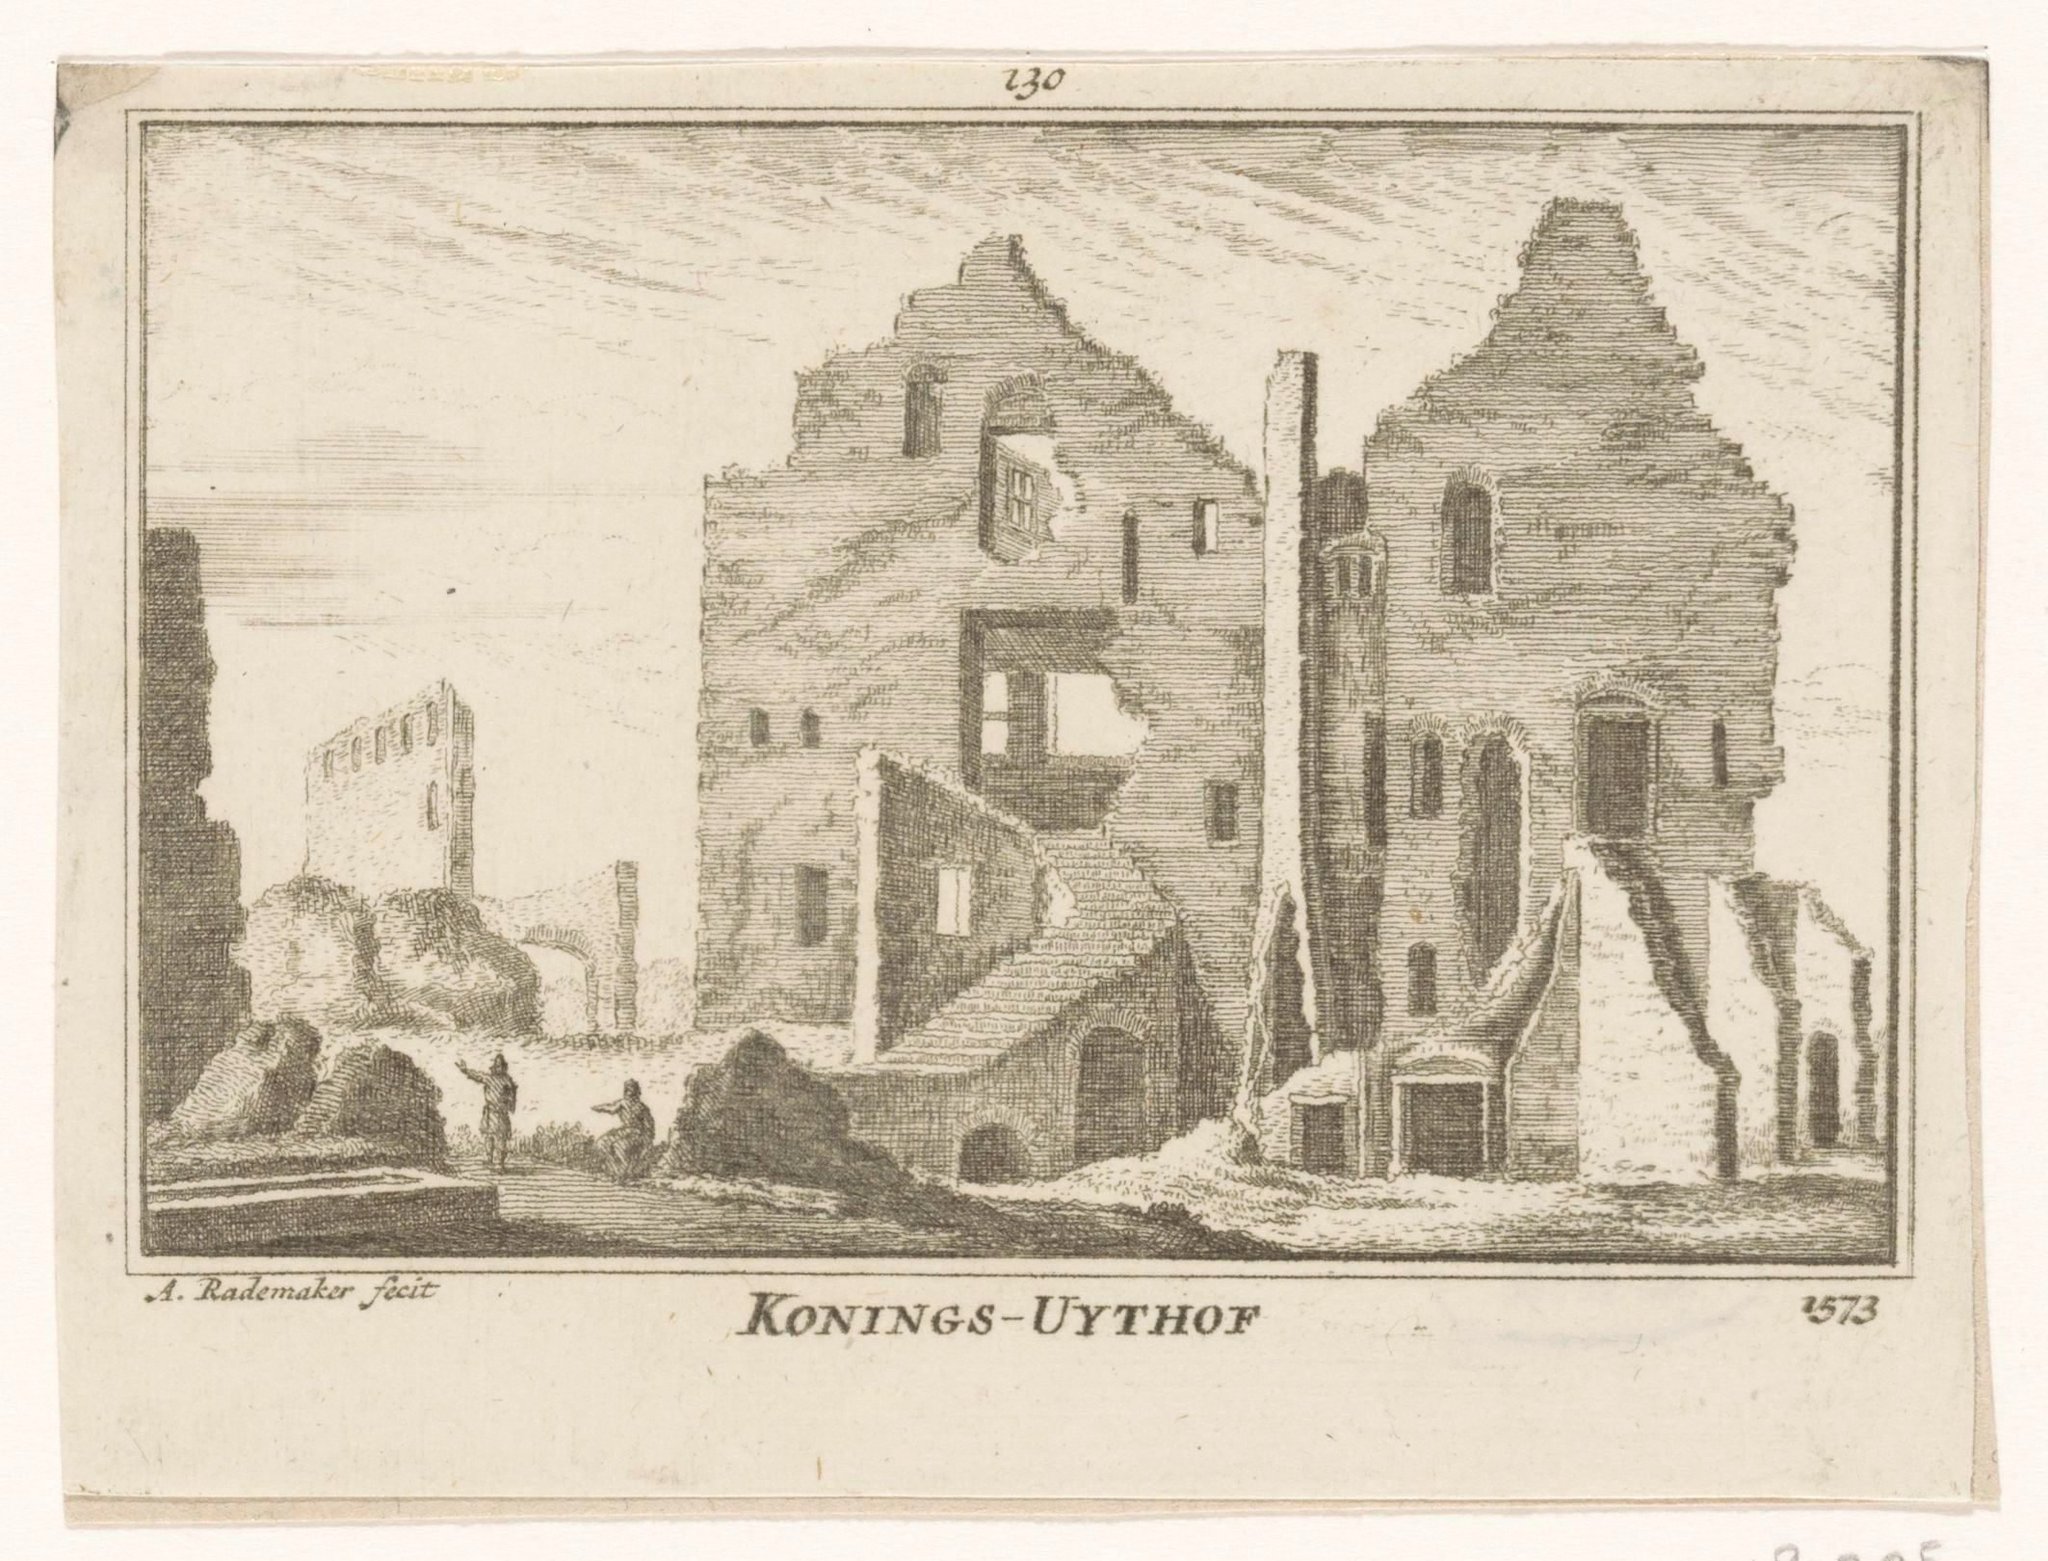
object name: print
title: Konings-Uythof 1573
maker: abraham rademaker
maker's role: draughtsman, print maker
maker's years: 1676-1735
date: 1725-1803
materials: paper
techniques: engraving, etching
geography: amsterdam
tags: ruin of church, monastery, etc., staircase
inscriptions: collector's mark: Lugt 2228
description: Prent ook gebruikt in: Rademaker, Abraham. Kabinet van Nederlandsche outheden en gezichten: vervat in 300 konstplaaten (…). 2 delen. Amsterdam: Willem Barents, 1725, dl. 1, ill. 130. Na 1725 is deze prent nog in verschillende heruitgaven verschenen, uitgegeven in 1727-1733, 1770-1771 en 1792-1803. Uit welke uitgave het huidige exemplaar precies komt is niet na te gaan.